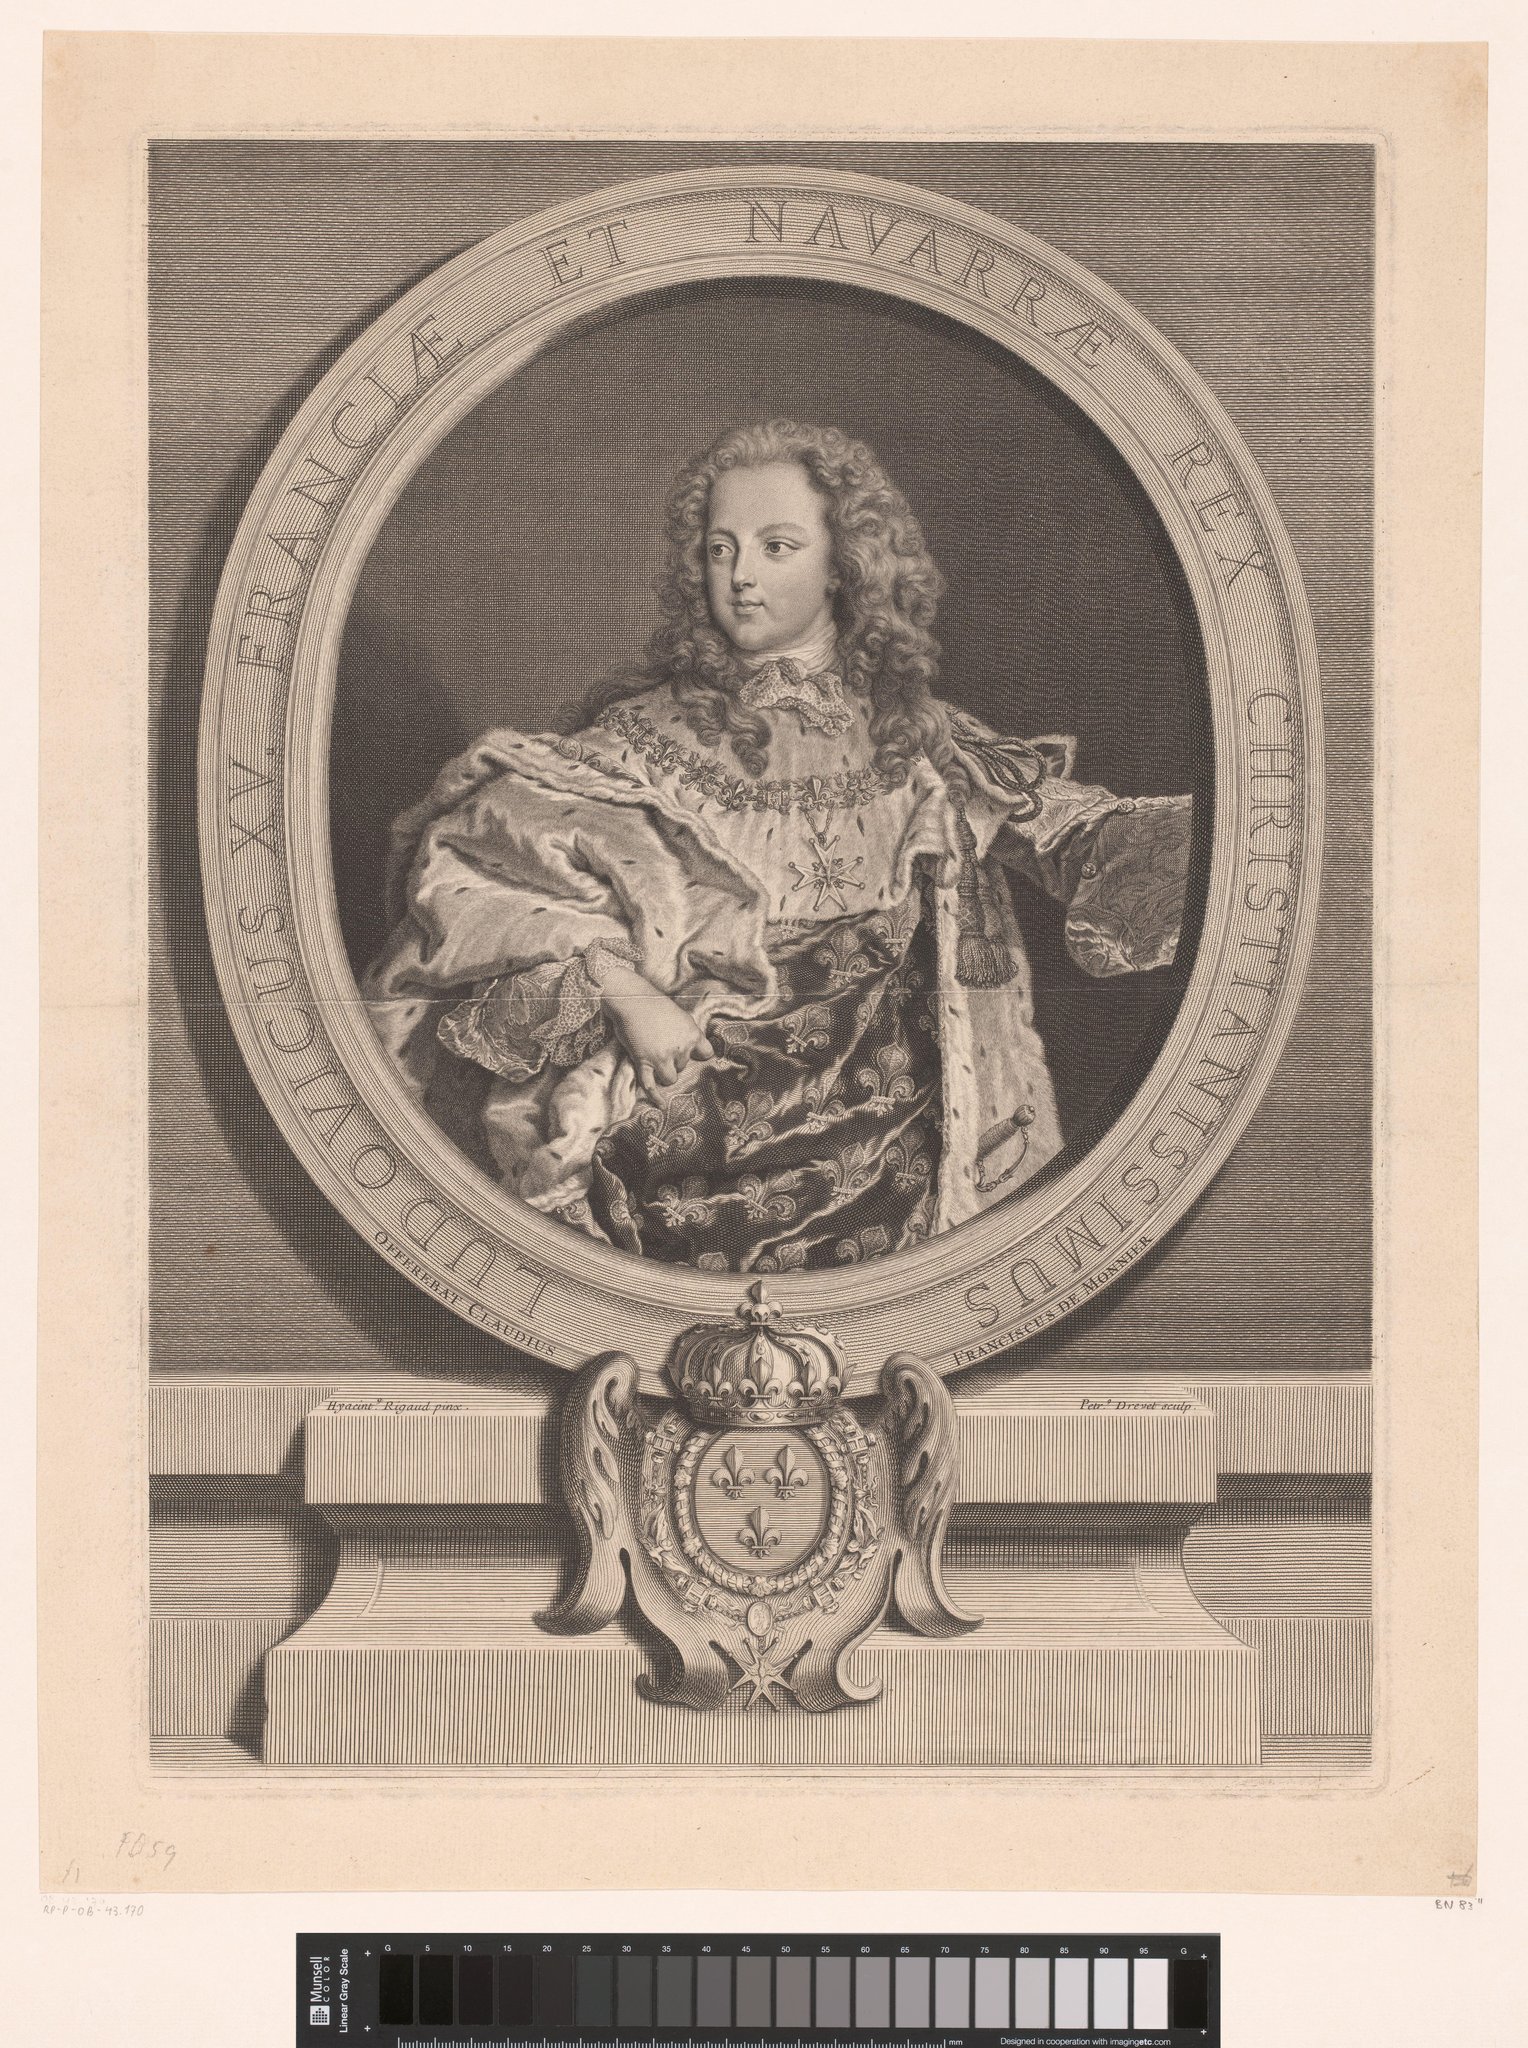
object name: print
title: Portret van Lodewijk XV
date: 1720-1738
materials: paper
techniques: engraving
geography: france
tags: louis xv of france, ornament ~ medallion, historical persons, ruler, sovereign, armorial bearing, heraldry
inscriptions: collector's mark: Lugt 240